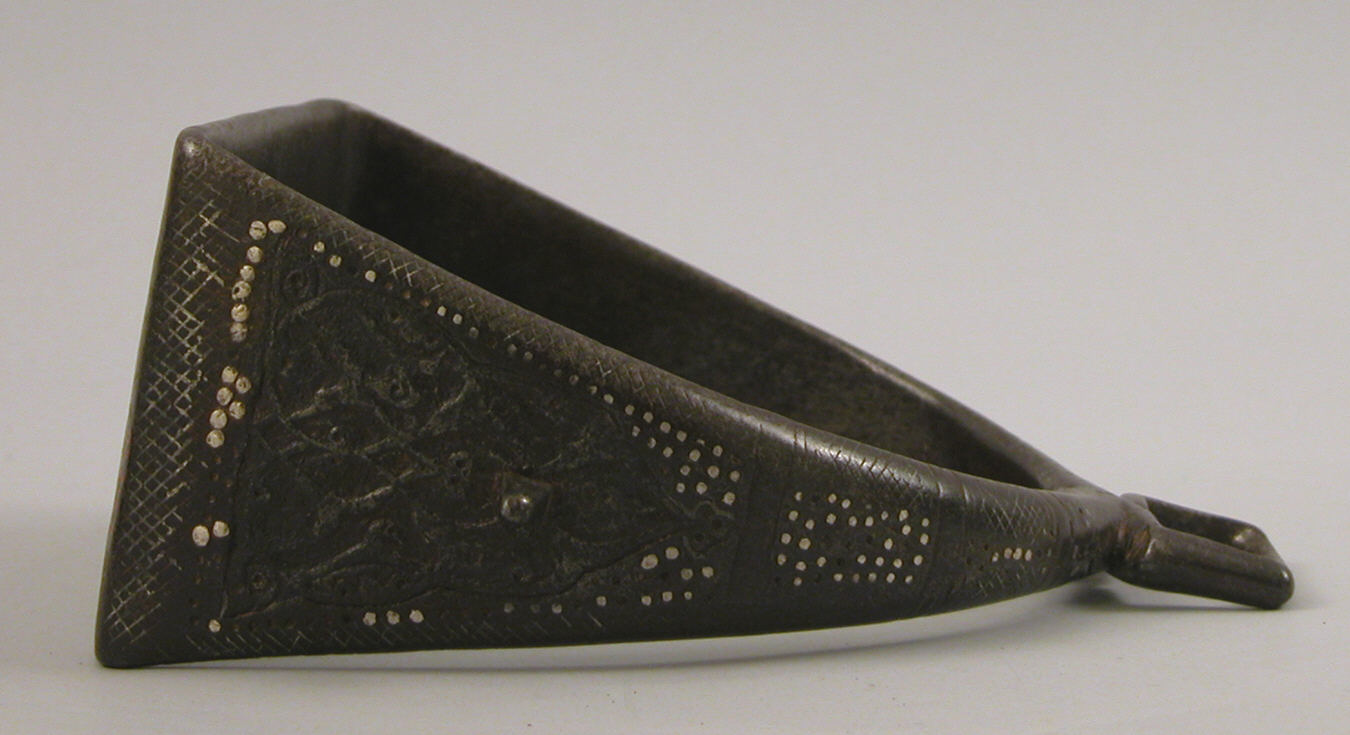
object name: stirrup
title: Stirrups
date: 1401-1500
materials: iron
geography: egypt